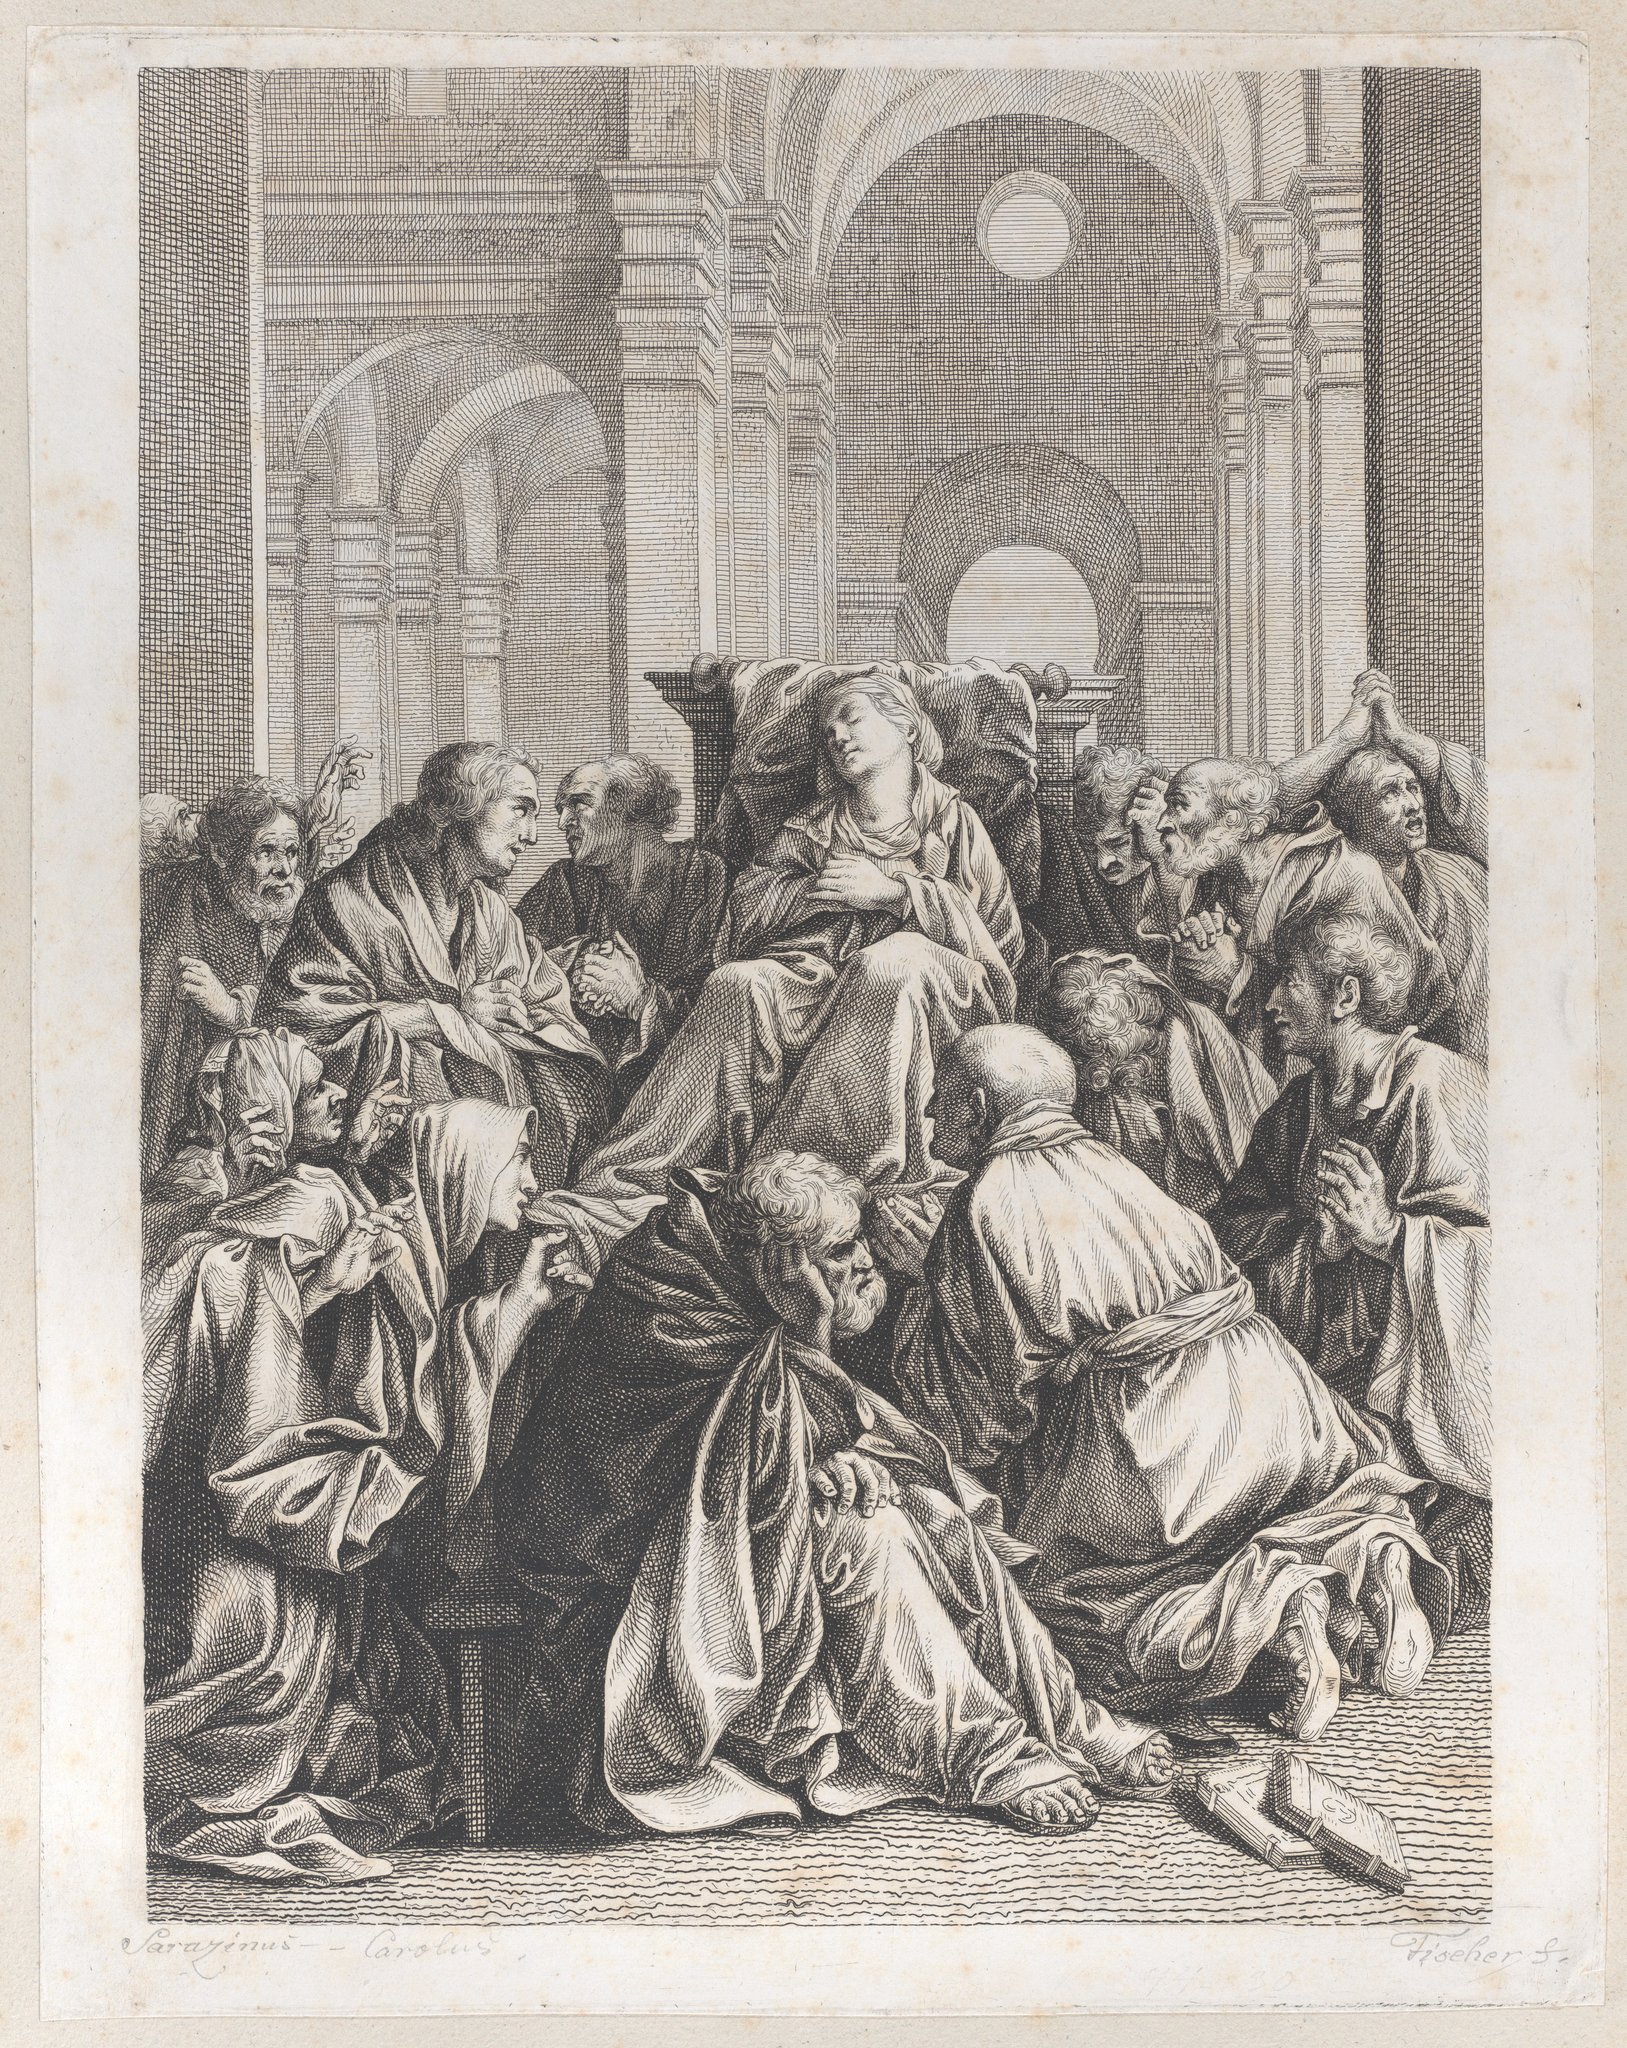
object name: print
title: Death of the Virgin, lying on a chair at center, surrounded by Apostles, inside a temple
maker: joseph fischer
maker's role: artist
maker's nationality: austrian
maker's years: 1769-1822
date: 1790-1822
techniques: etching